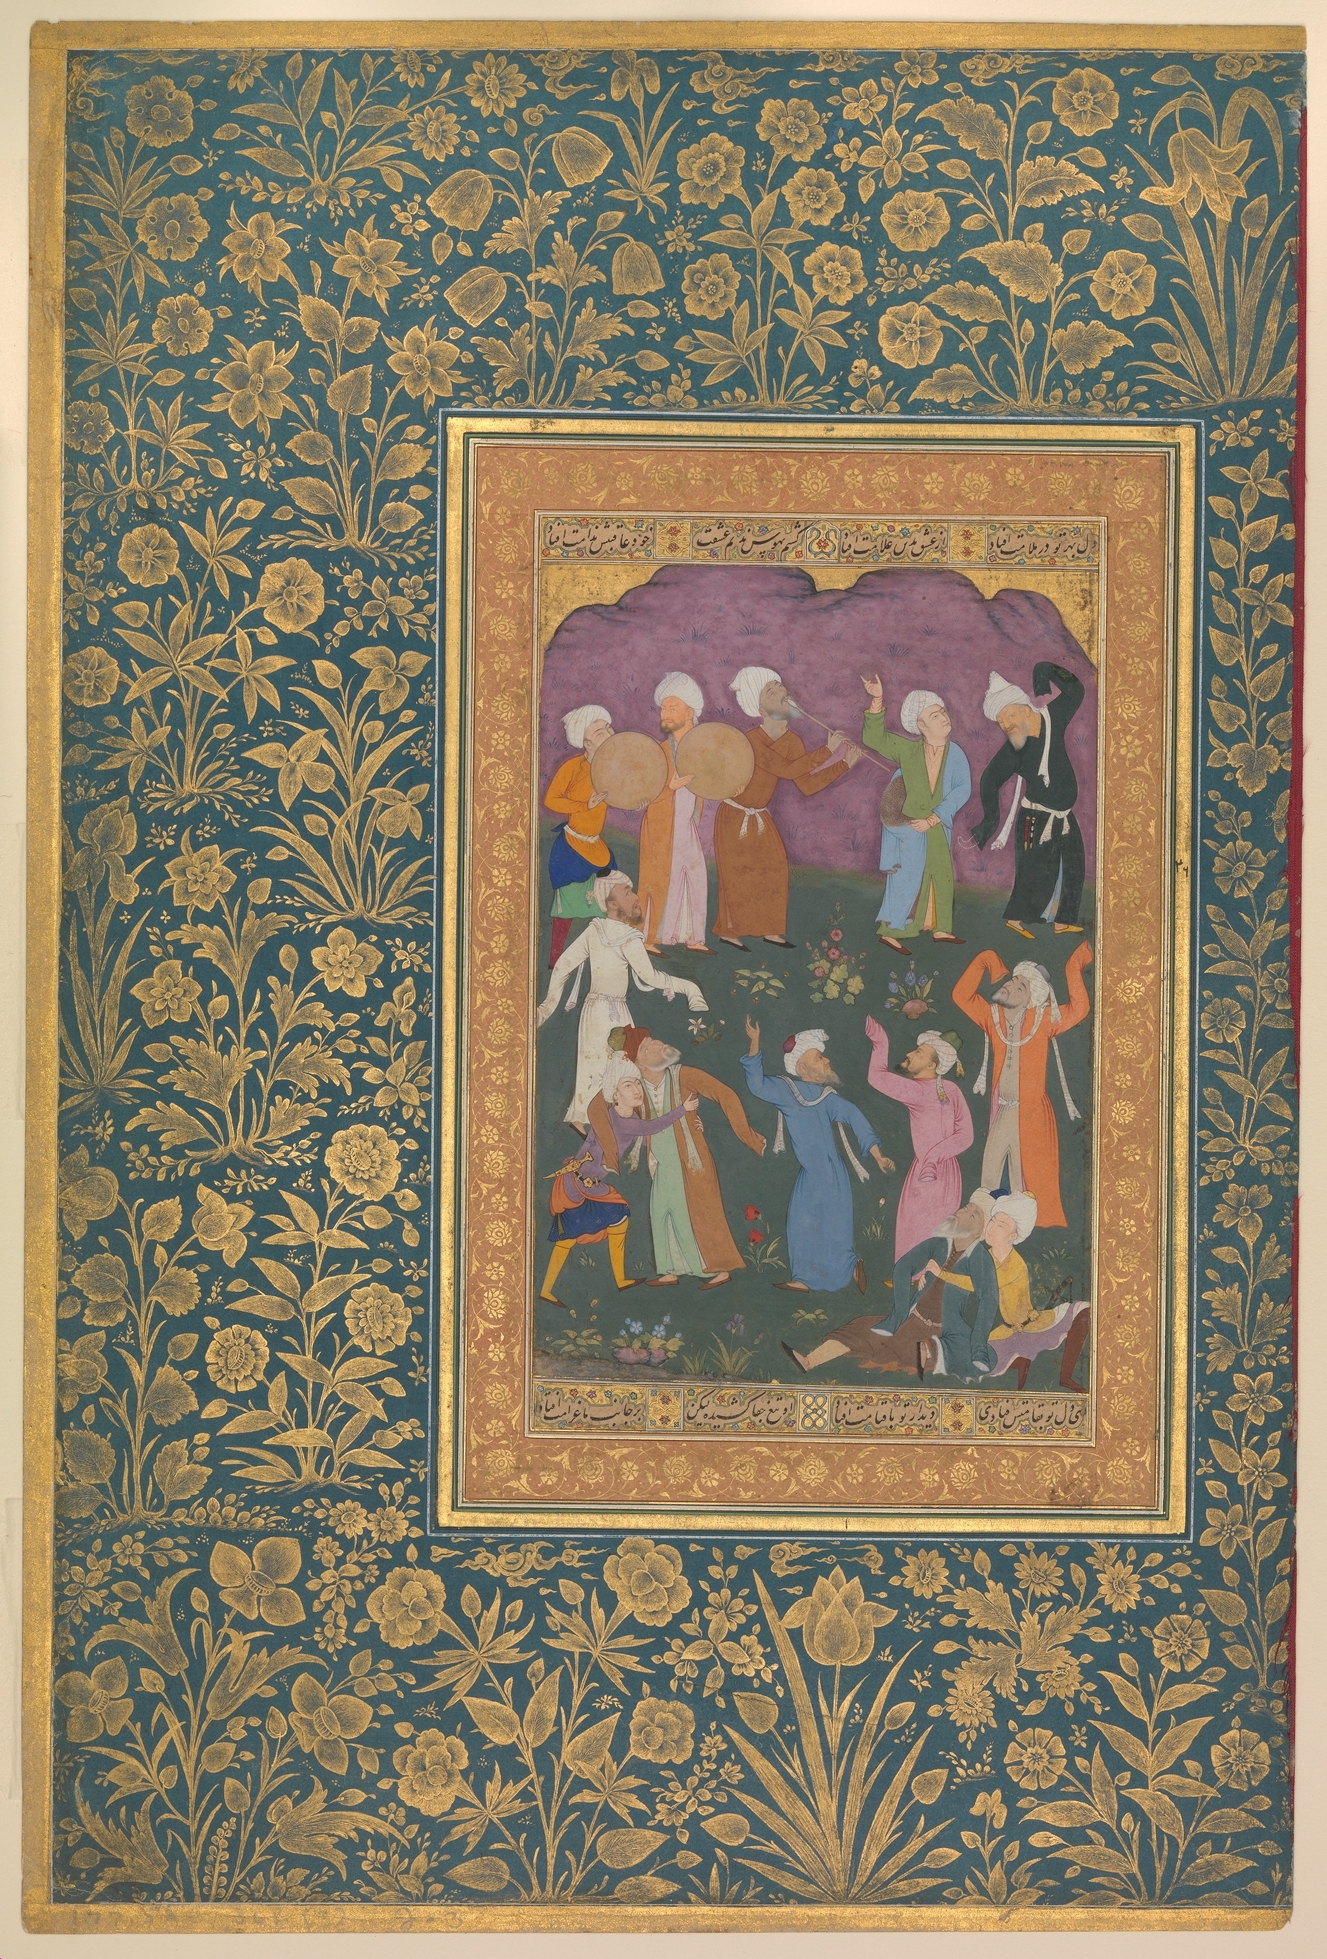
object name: album leaf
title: "Dancing Dervishes", Folio from the Shah Jahan Album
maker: mir 'ali haravi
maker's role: calligrapher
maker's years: 1525-1575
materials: gold, ink, paper, watercolor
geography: india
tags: musical instruments,men,dancing,music